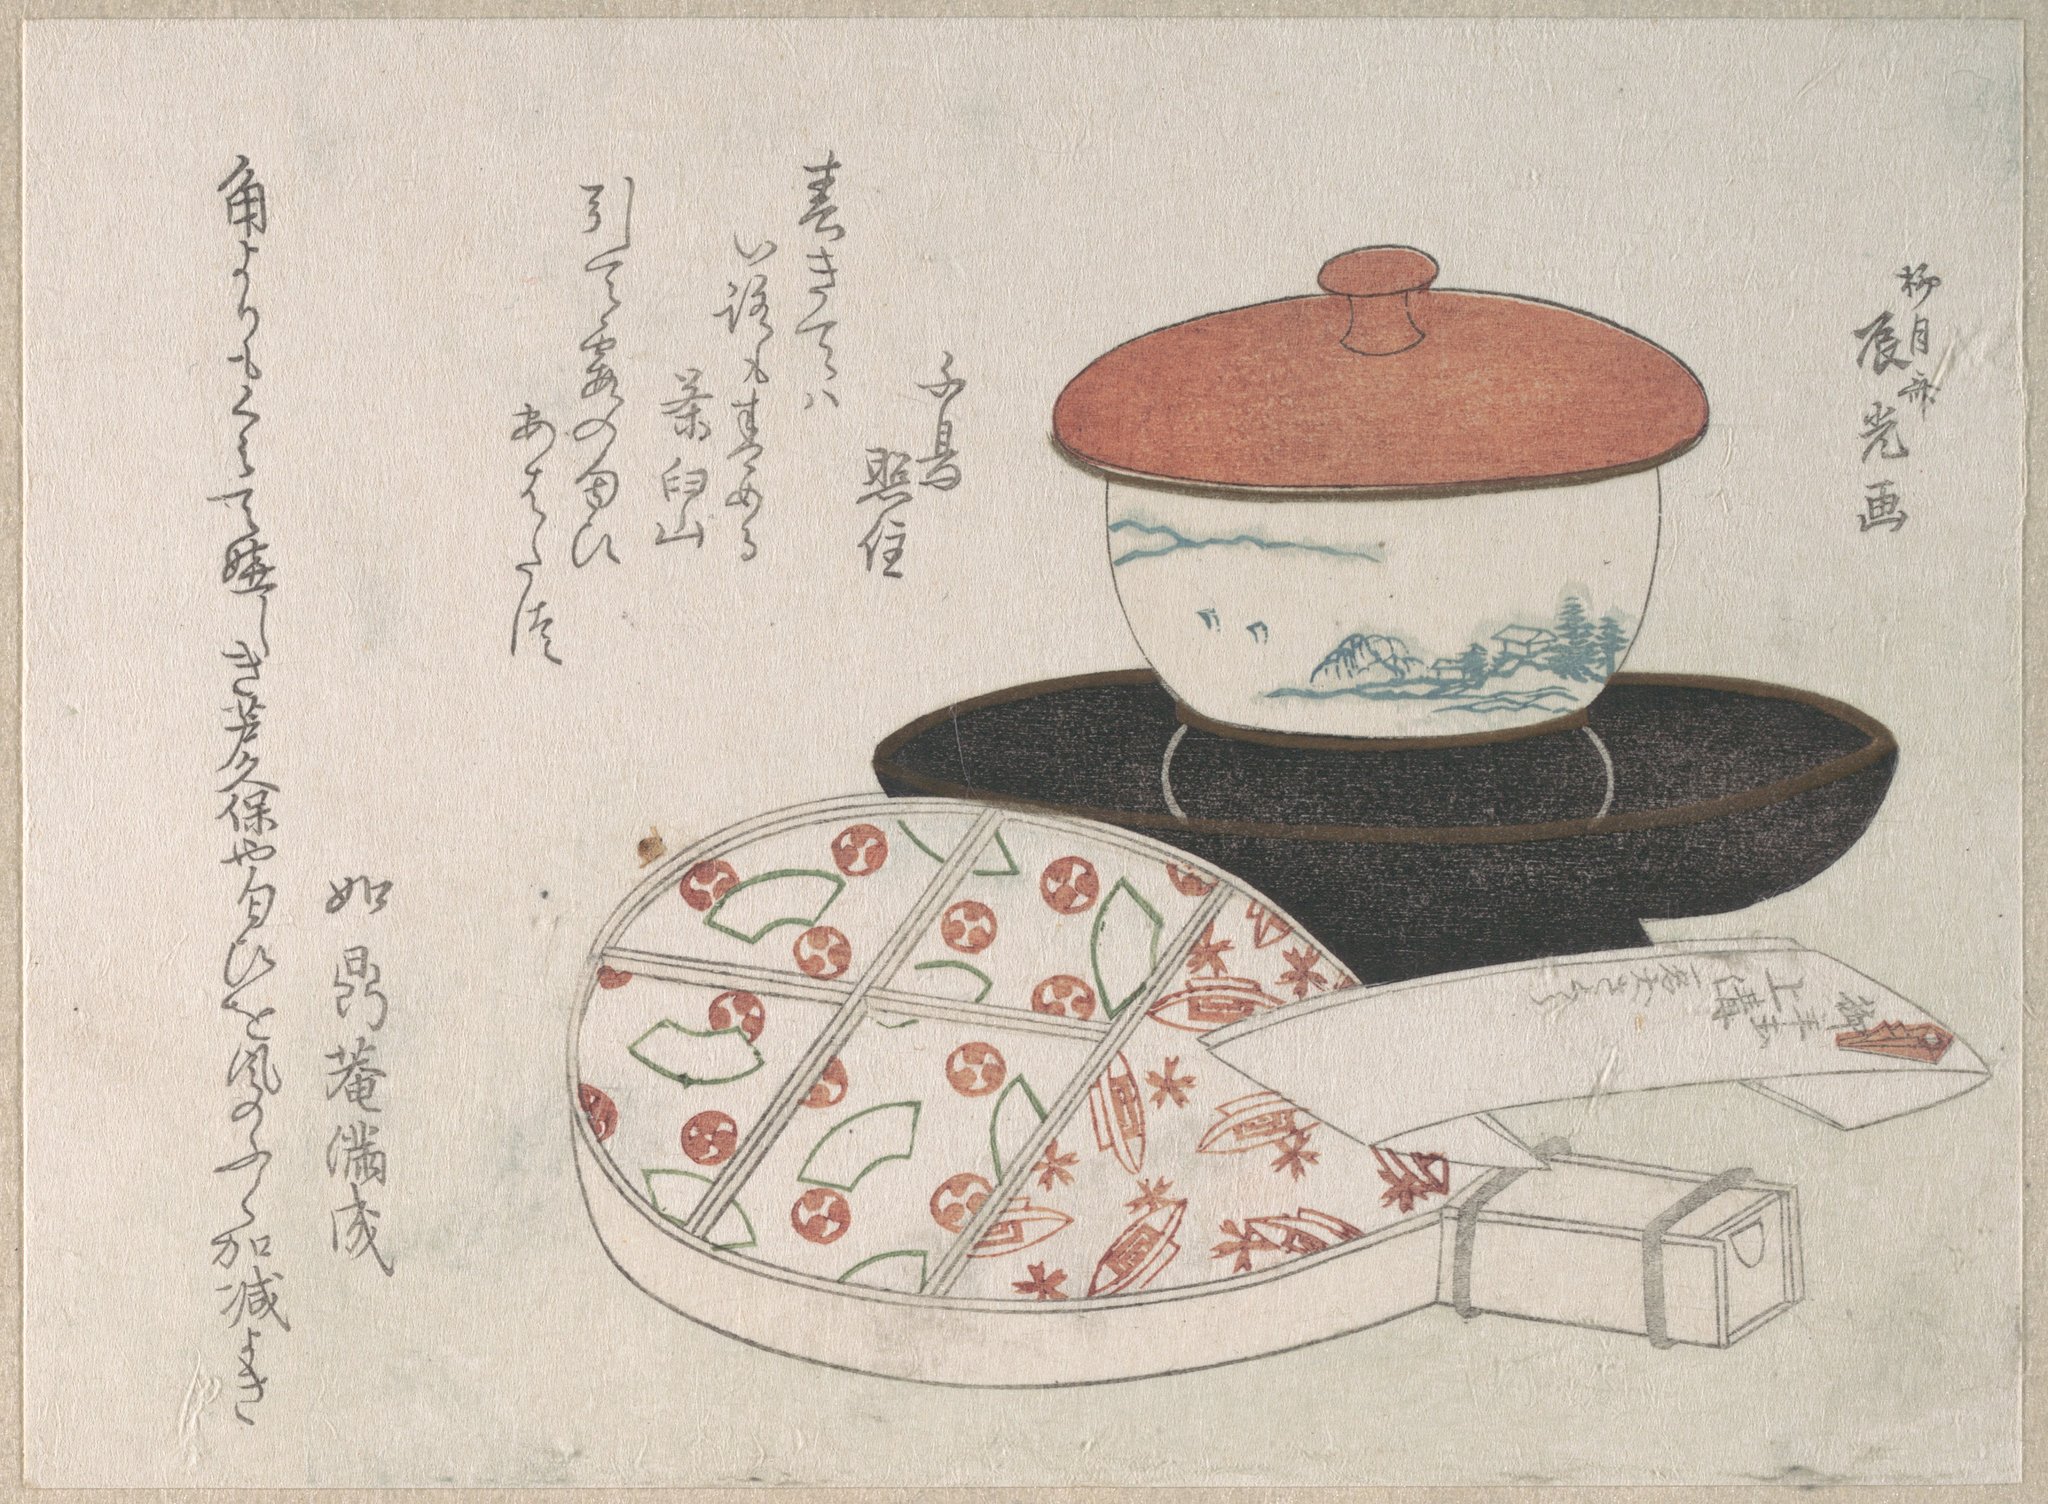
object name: print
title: Teacup and Tea Heater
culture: japanese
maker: ryūgetsusai shinkō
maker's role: artist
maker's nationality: japanese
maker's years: 1810-1819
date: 1700-1899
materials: ink, paper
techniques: surimono, woodblock print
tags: tea